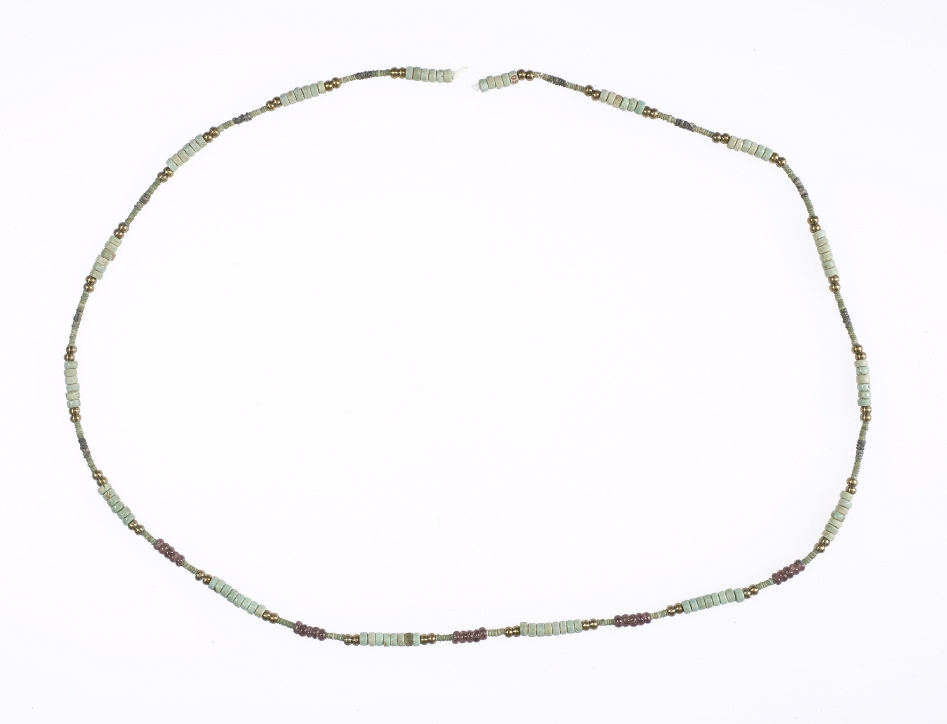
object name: bead, string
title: Hepy, String of beads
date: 1950-1885 BCE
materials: bronze, faience, gemstone, paste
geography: egypt